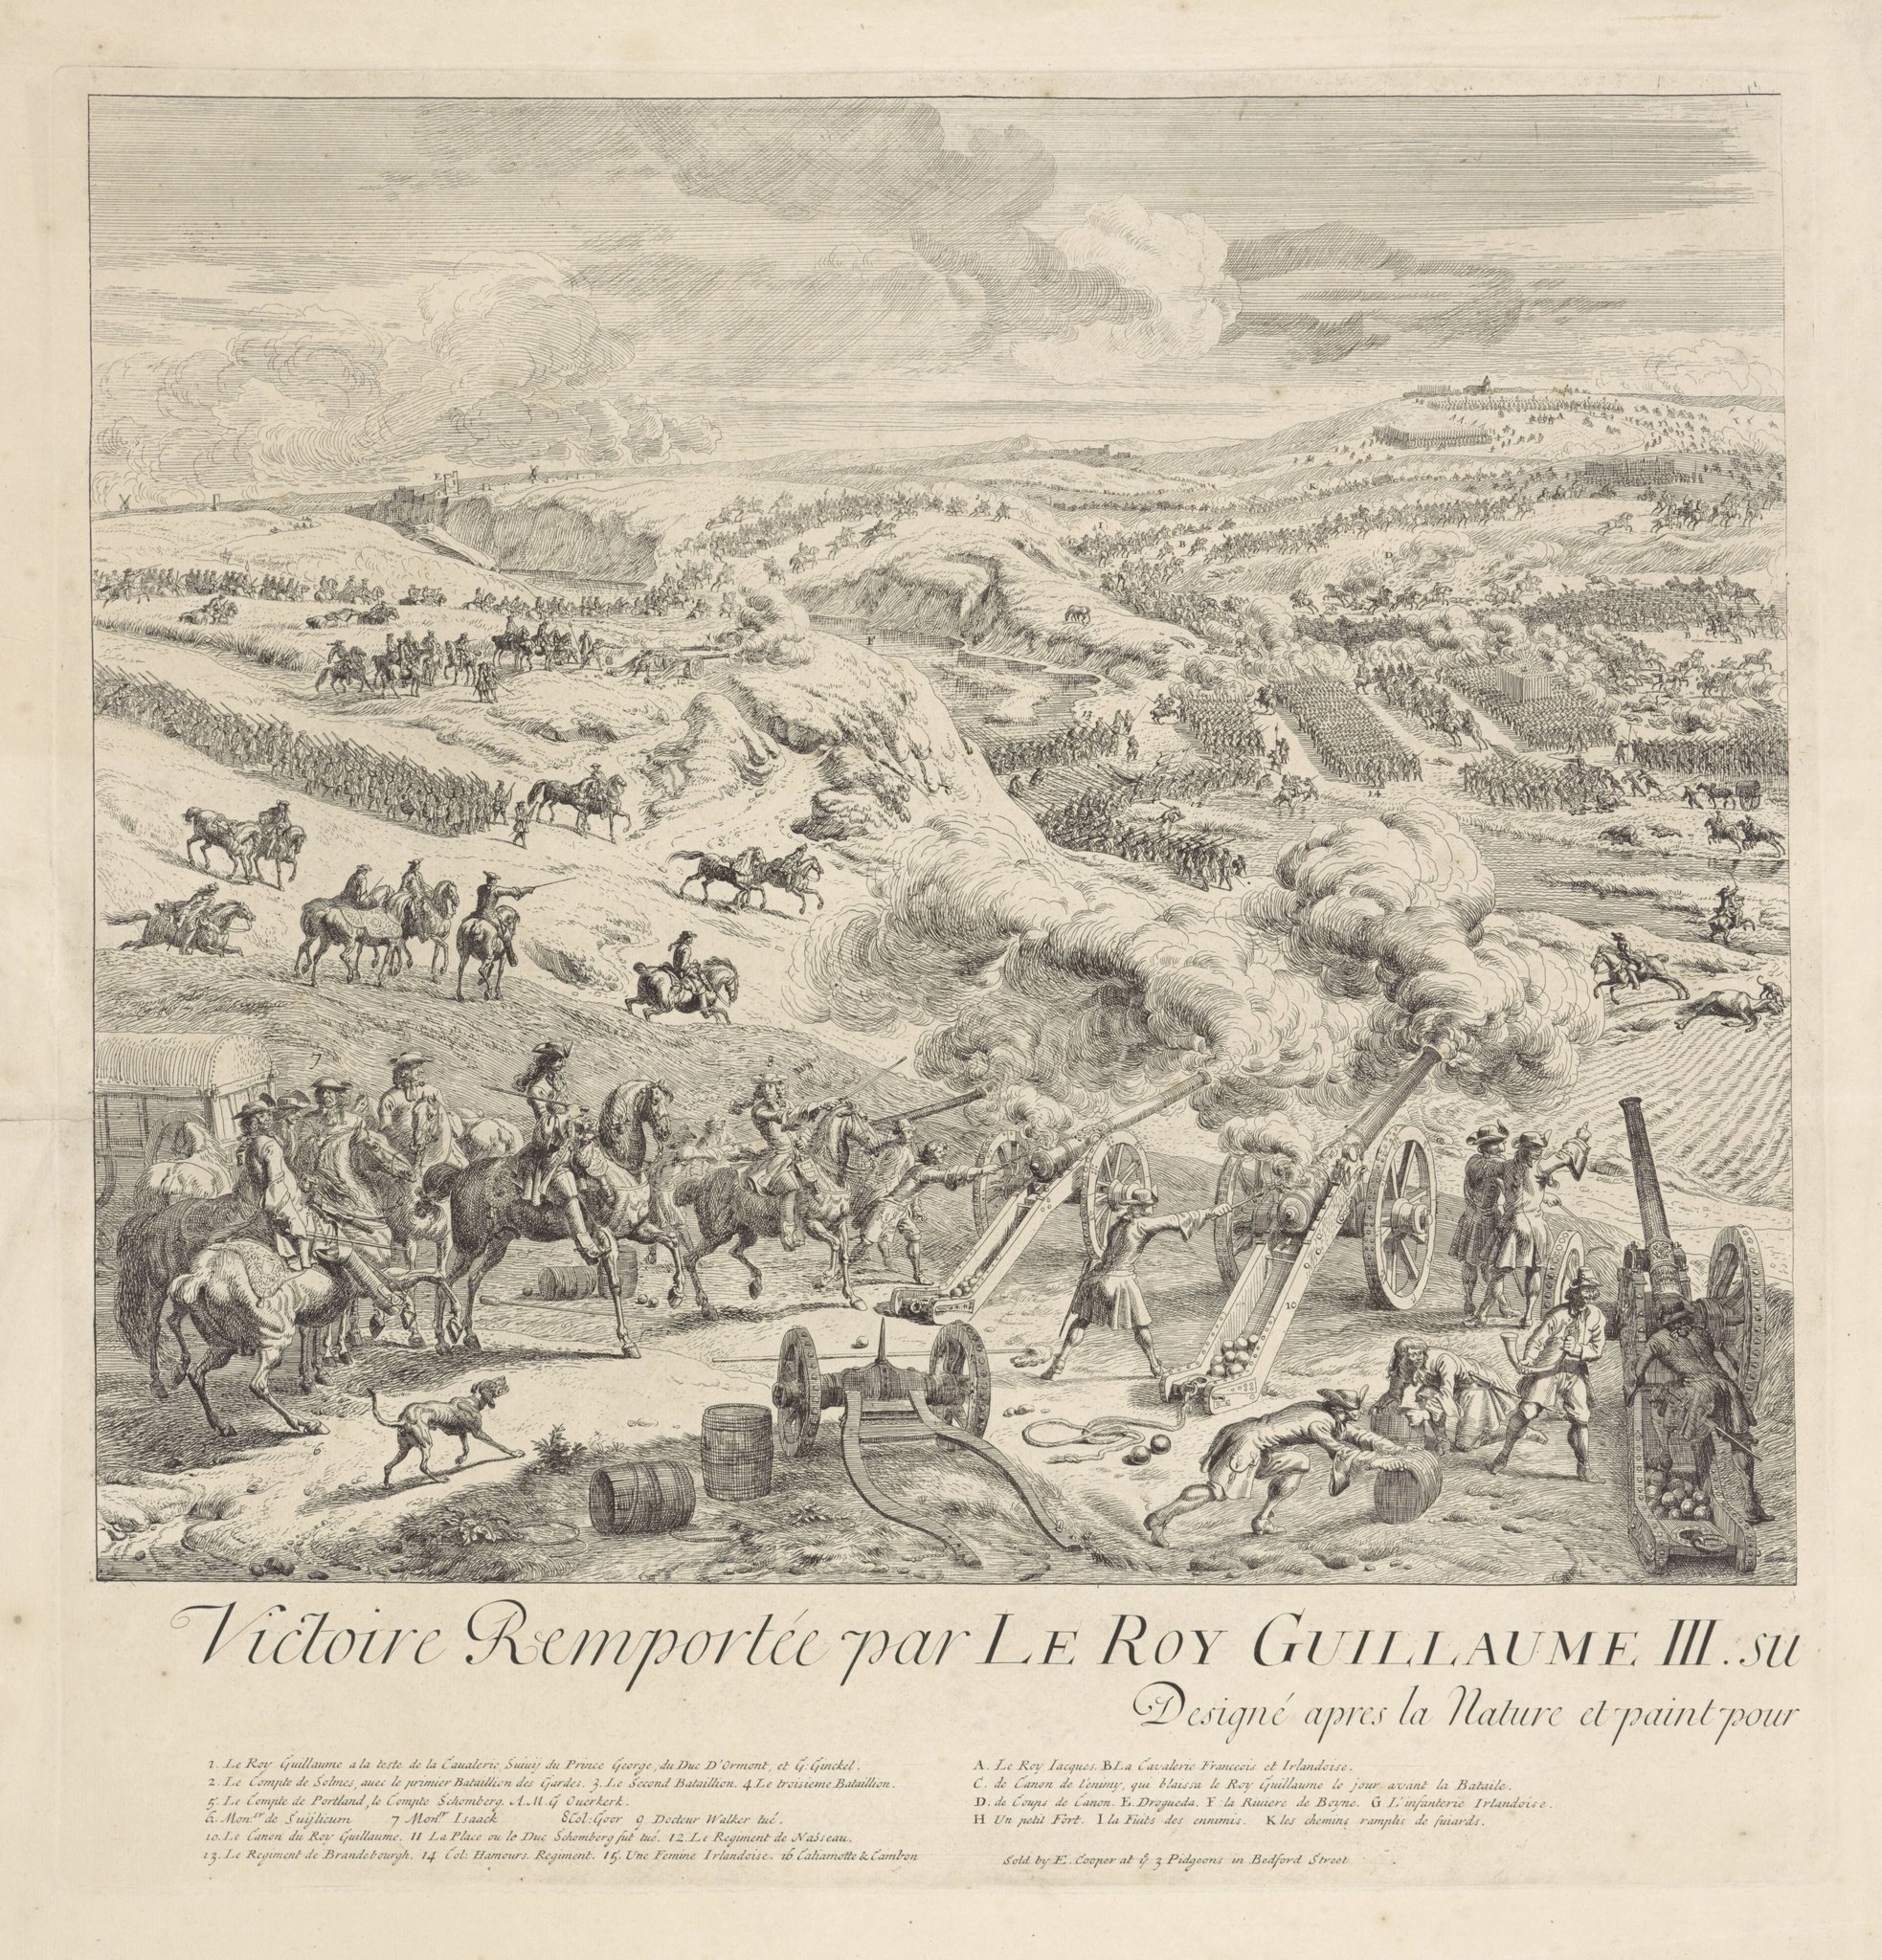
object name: print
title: Slag bij Drogheda aan de Boyne, 1 juli 1690 (linker blad)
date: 1690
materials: paper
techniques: etching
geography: england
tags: jacobus ii (koning van engeland en schotland), the hague, william iii (prince of orange and king of england, scotland, and ireland), battle (+ naval force)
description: Linkerblad van een voorstelling op twee losse bladen van de slag bij de rivier de Boyne op 11 juli 1690, waarbij het leger van Willem III een overwinning behaalt op de katholieken onder Jacobus II. Op de voorgrond vurende kanonnen, links in de verte Drogheda. In het onderschrift de legenda 1-16 en A-K in het Frans.